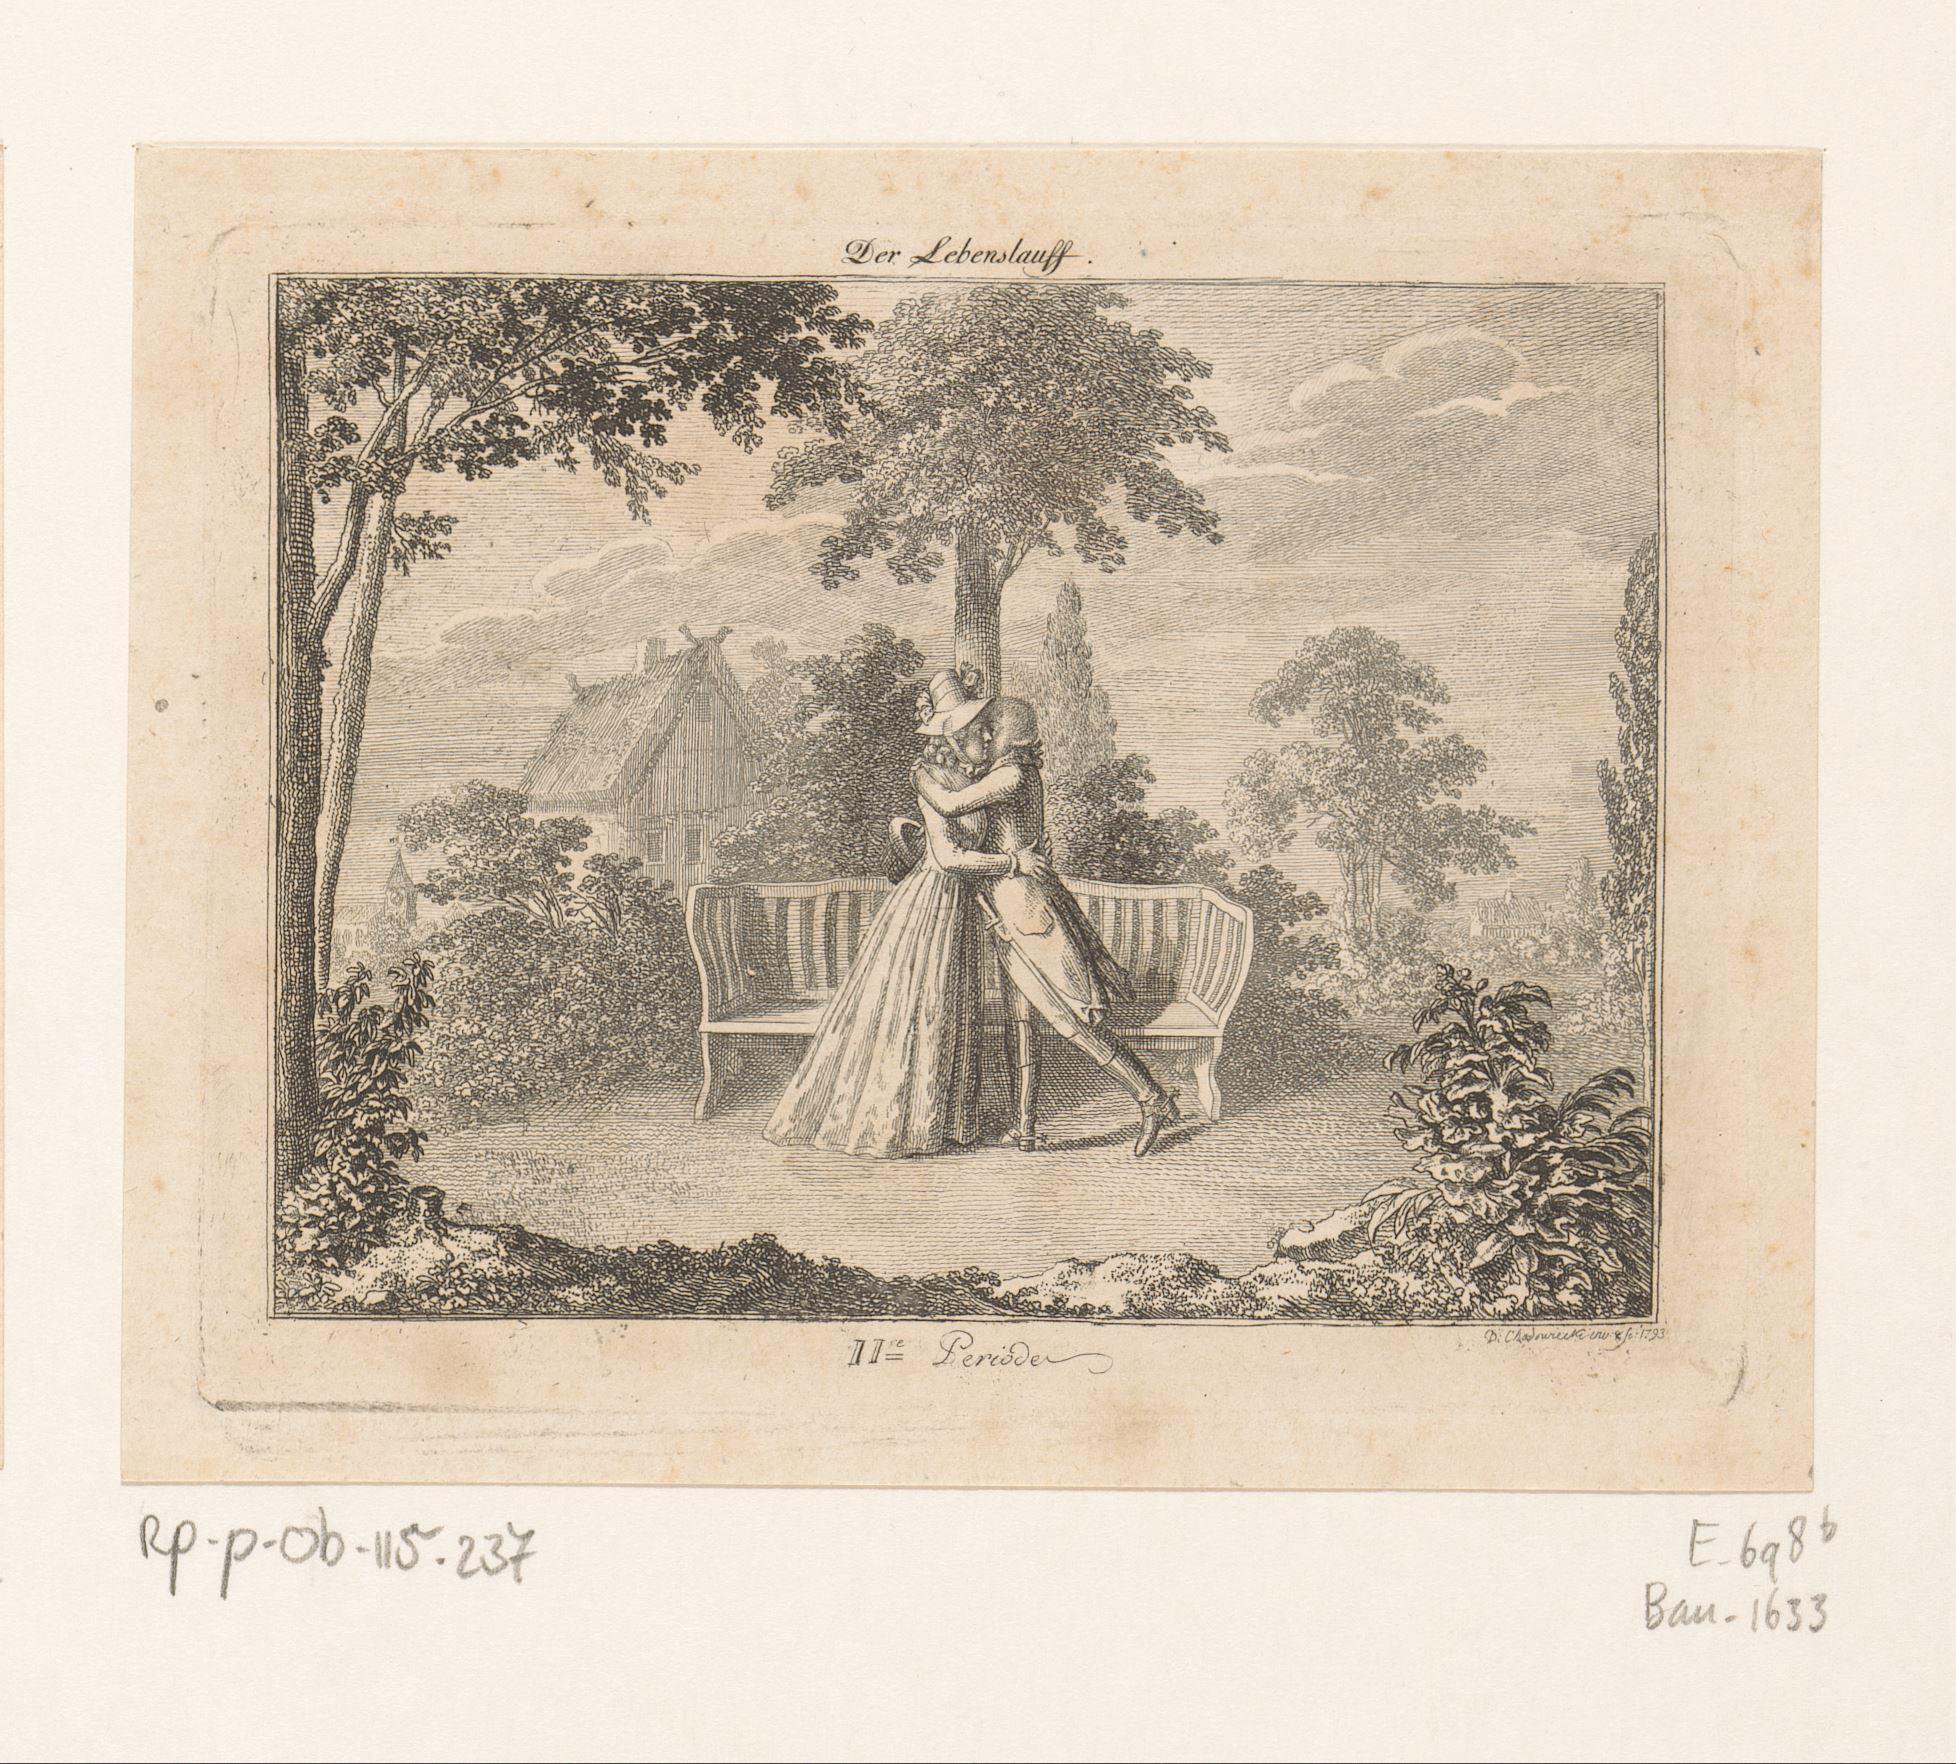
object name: print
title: Der Lebenslauf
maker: daniel nikolaus chodowiecki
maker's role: draughtsman, print maker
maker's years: 1726-1801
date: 1793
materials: paper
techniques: etching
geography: berlin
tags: mother and son(s) (family group), bench, child, embracing each other, kissing, youth, adolescent, farm or solitary house in landscape, the life of man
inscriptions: collector's mark: Lugt 2228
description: Onderdeel van een serie van acht prenten over de levensloop van de mens.